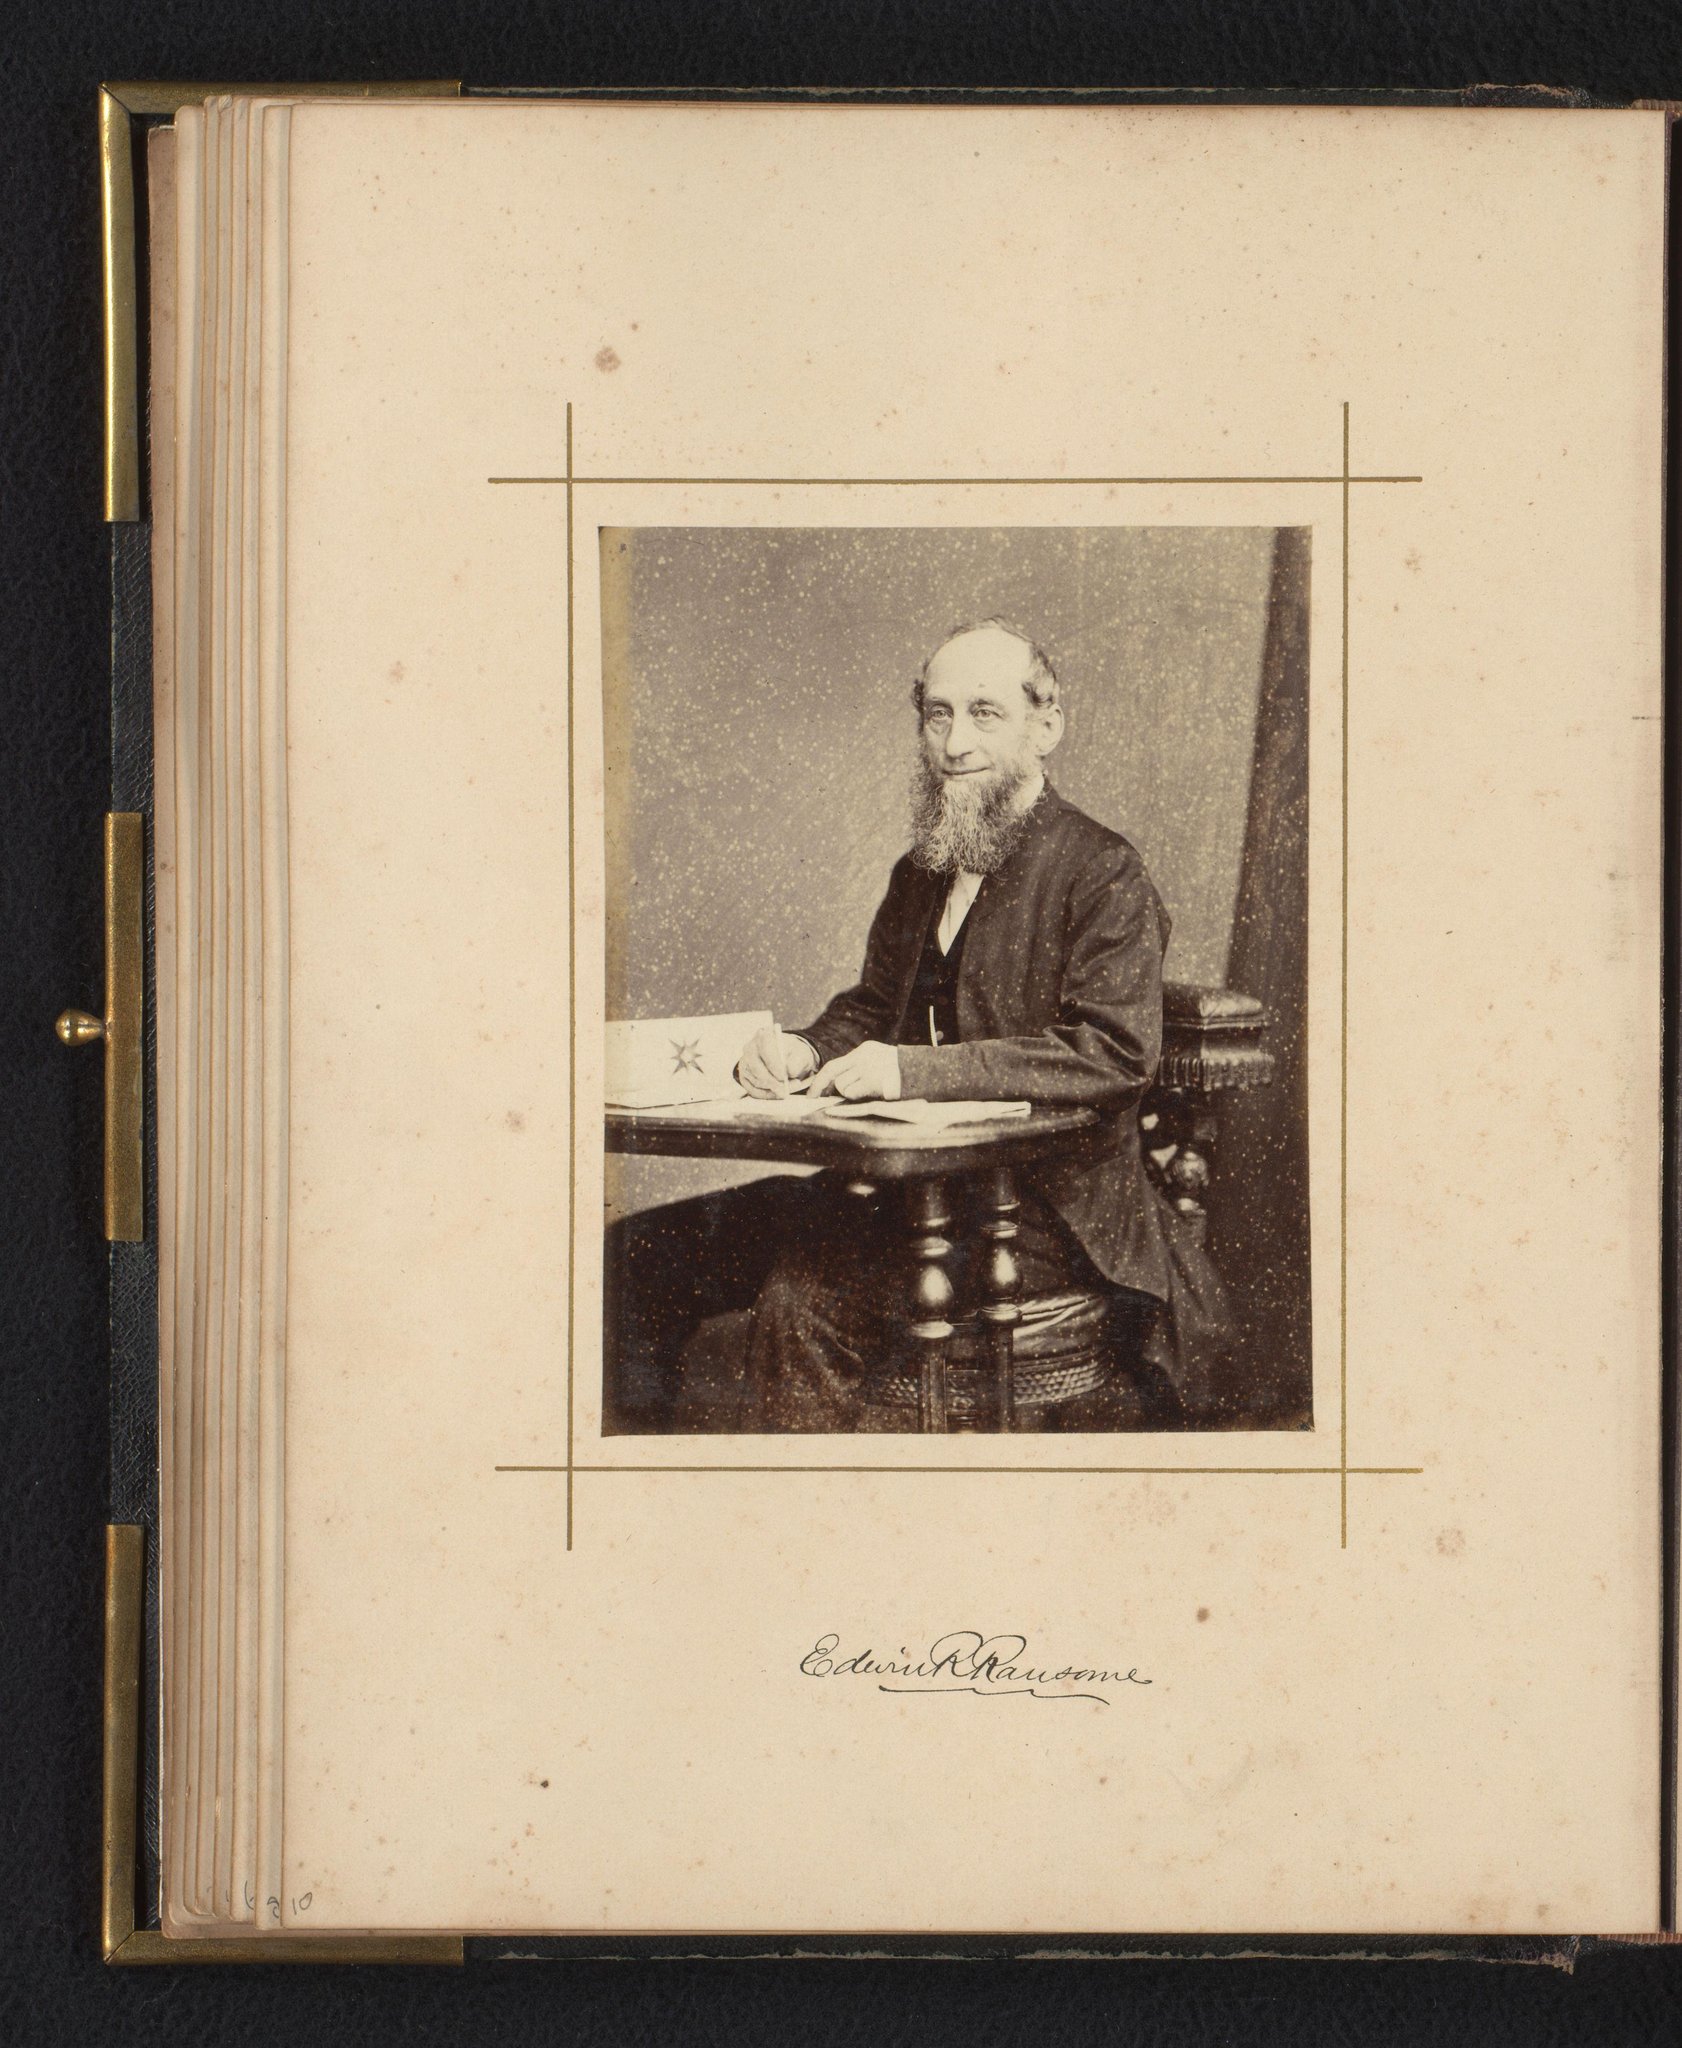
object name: photograph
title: Portret van een man, mogelijk Edwin R. Ransome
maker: Anonymous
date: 1866-1871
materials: photographic support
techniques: albumen print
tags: historical persons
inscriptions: name: ‘[Edwin R. Ransome]’